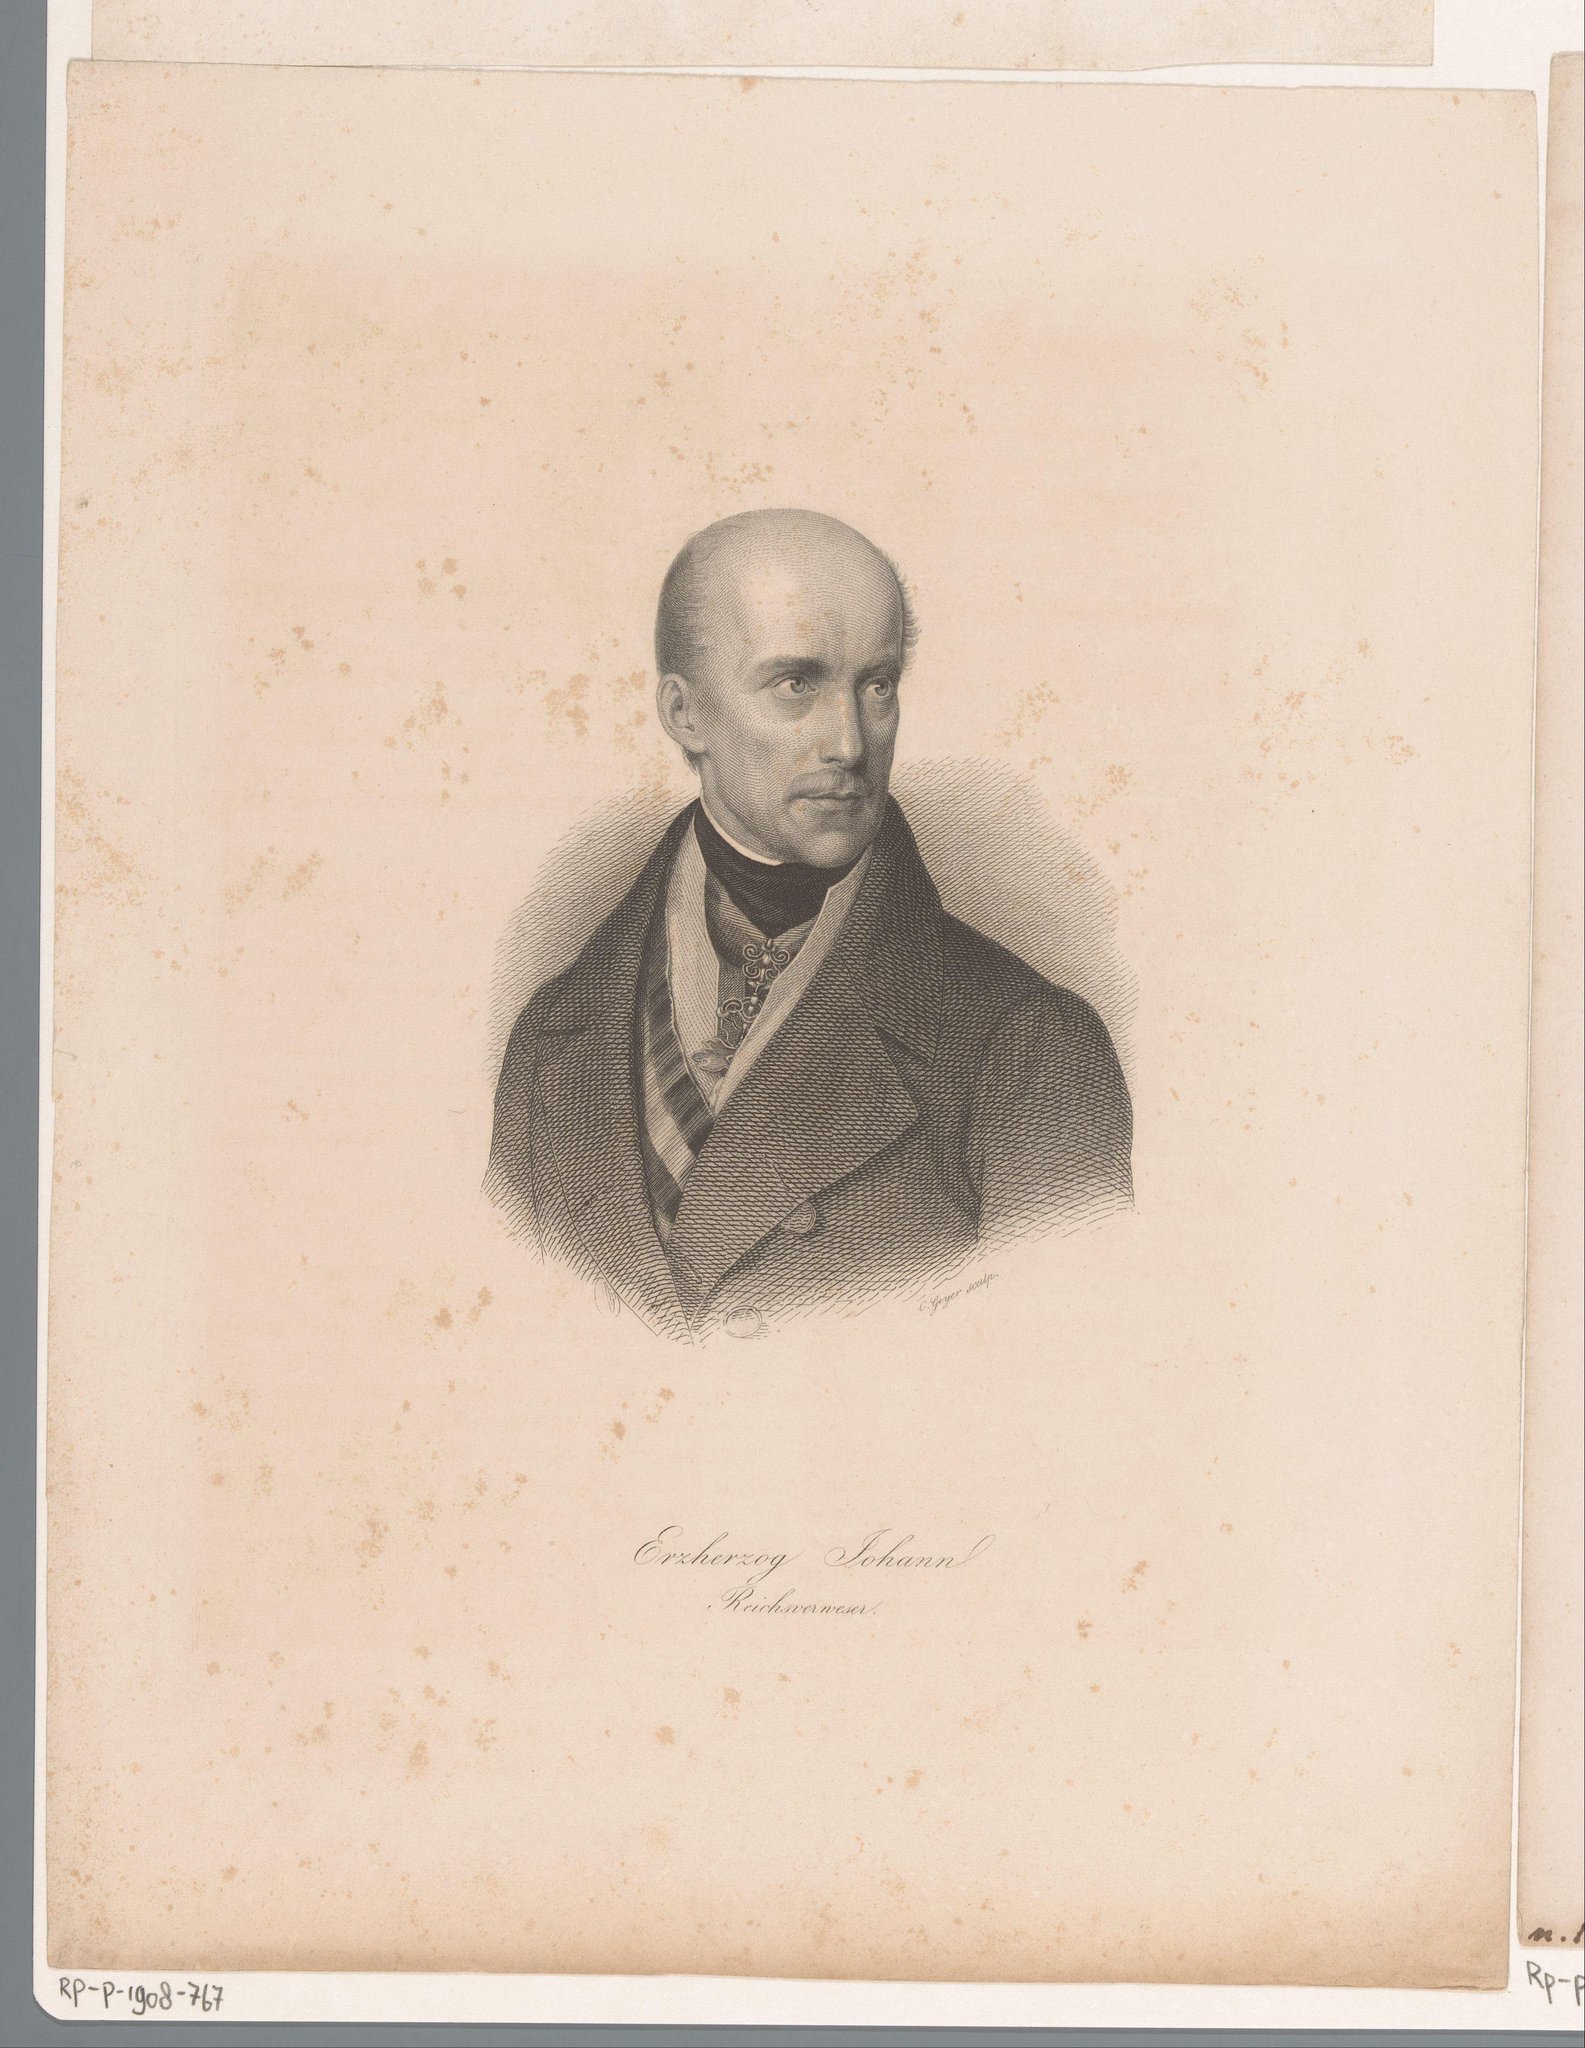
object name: print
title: Portret van Johan van Oostenrijk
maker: conrad geyer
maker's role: print maker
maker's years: 1816-1893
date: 1826-1893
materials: paper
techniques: engraving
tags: commander-in-chief, general, marshal, historical persons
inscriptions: collector's mark: Lugt 2228